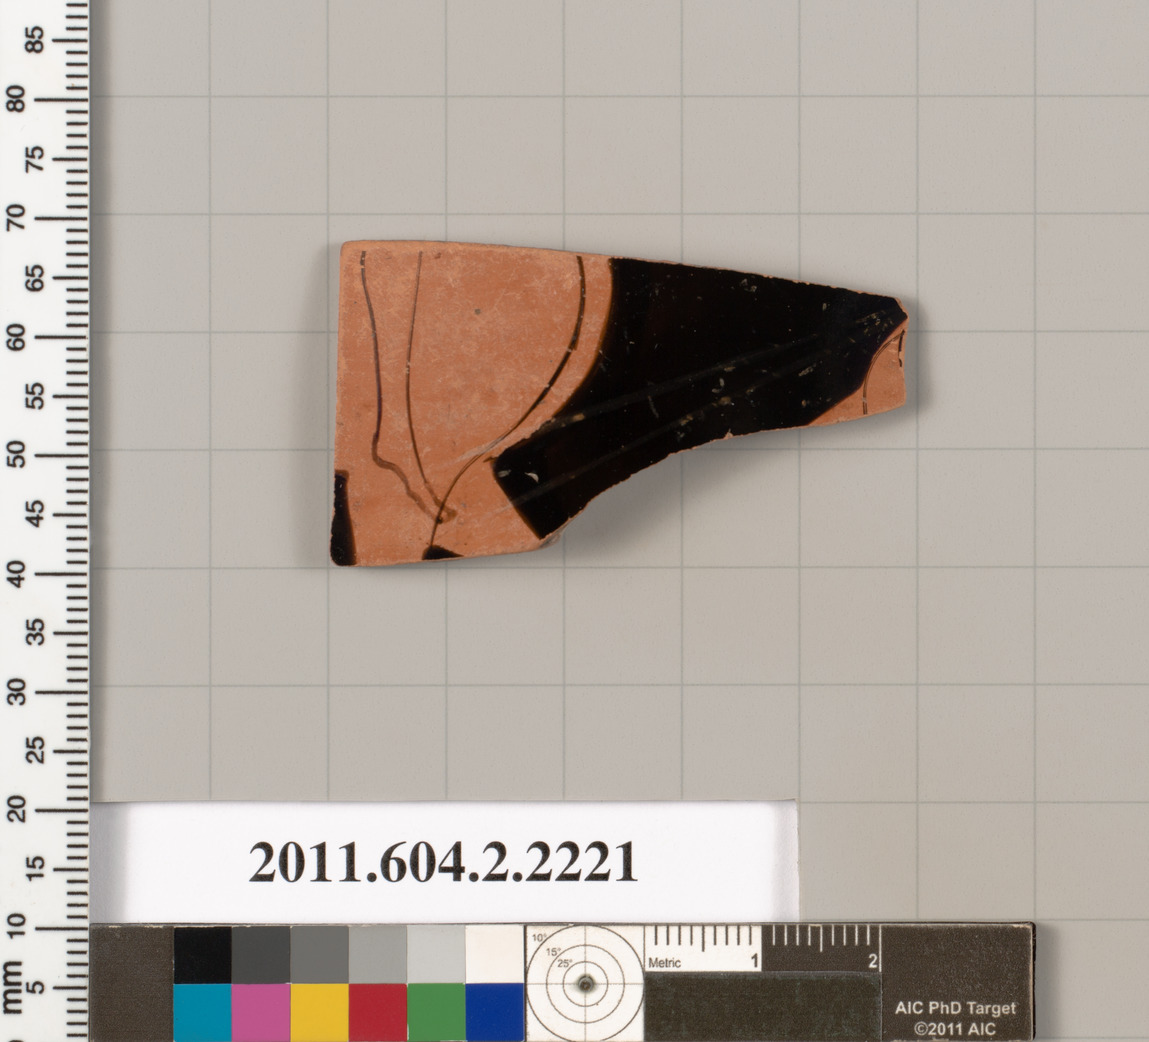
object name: pot fragment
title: Terracotta fragment of a pot; unglazed on the inside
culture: greek, attic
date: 475-451 BCE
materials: terracotta